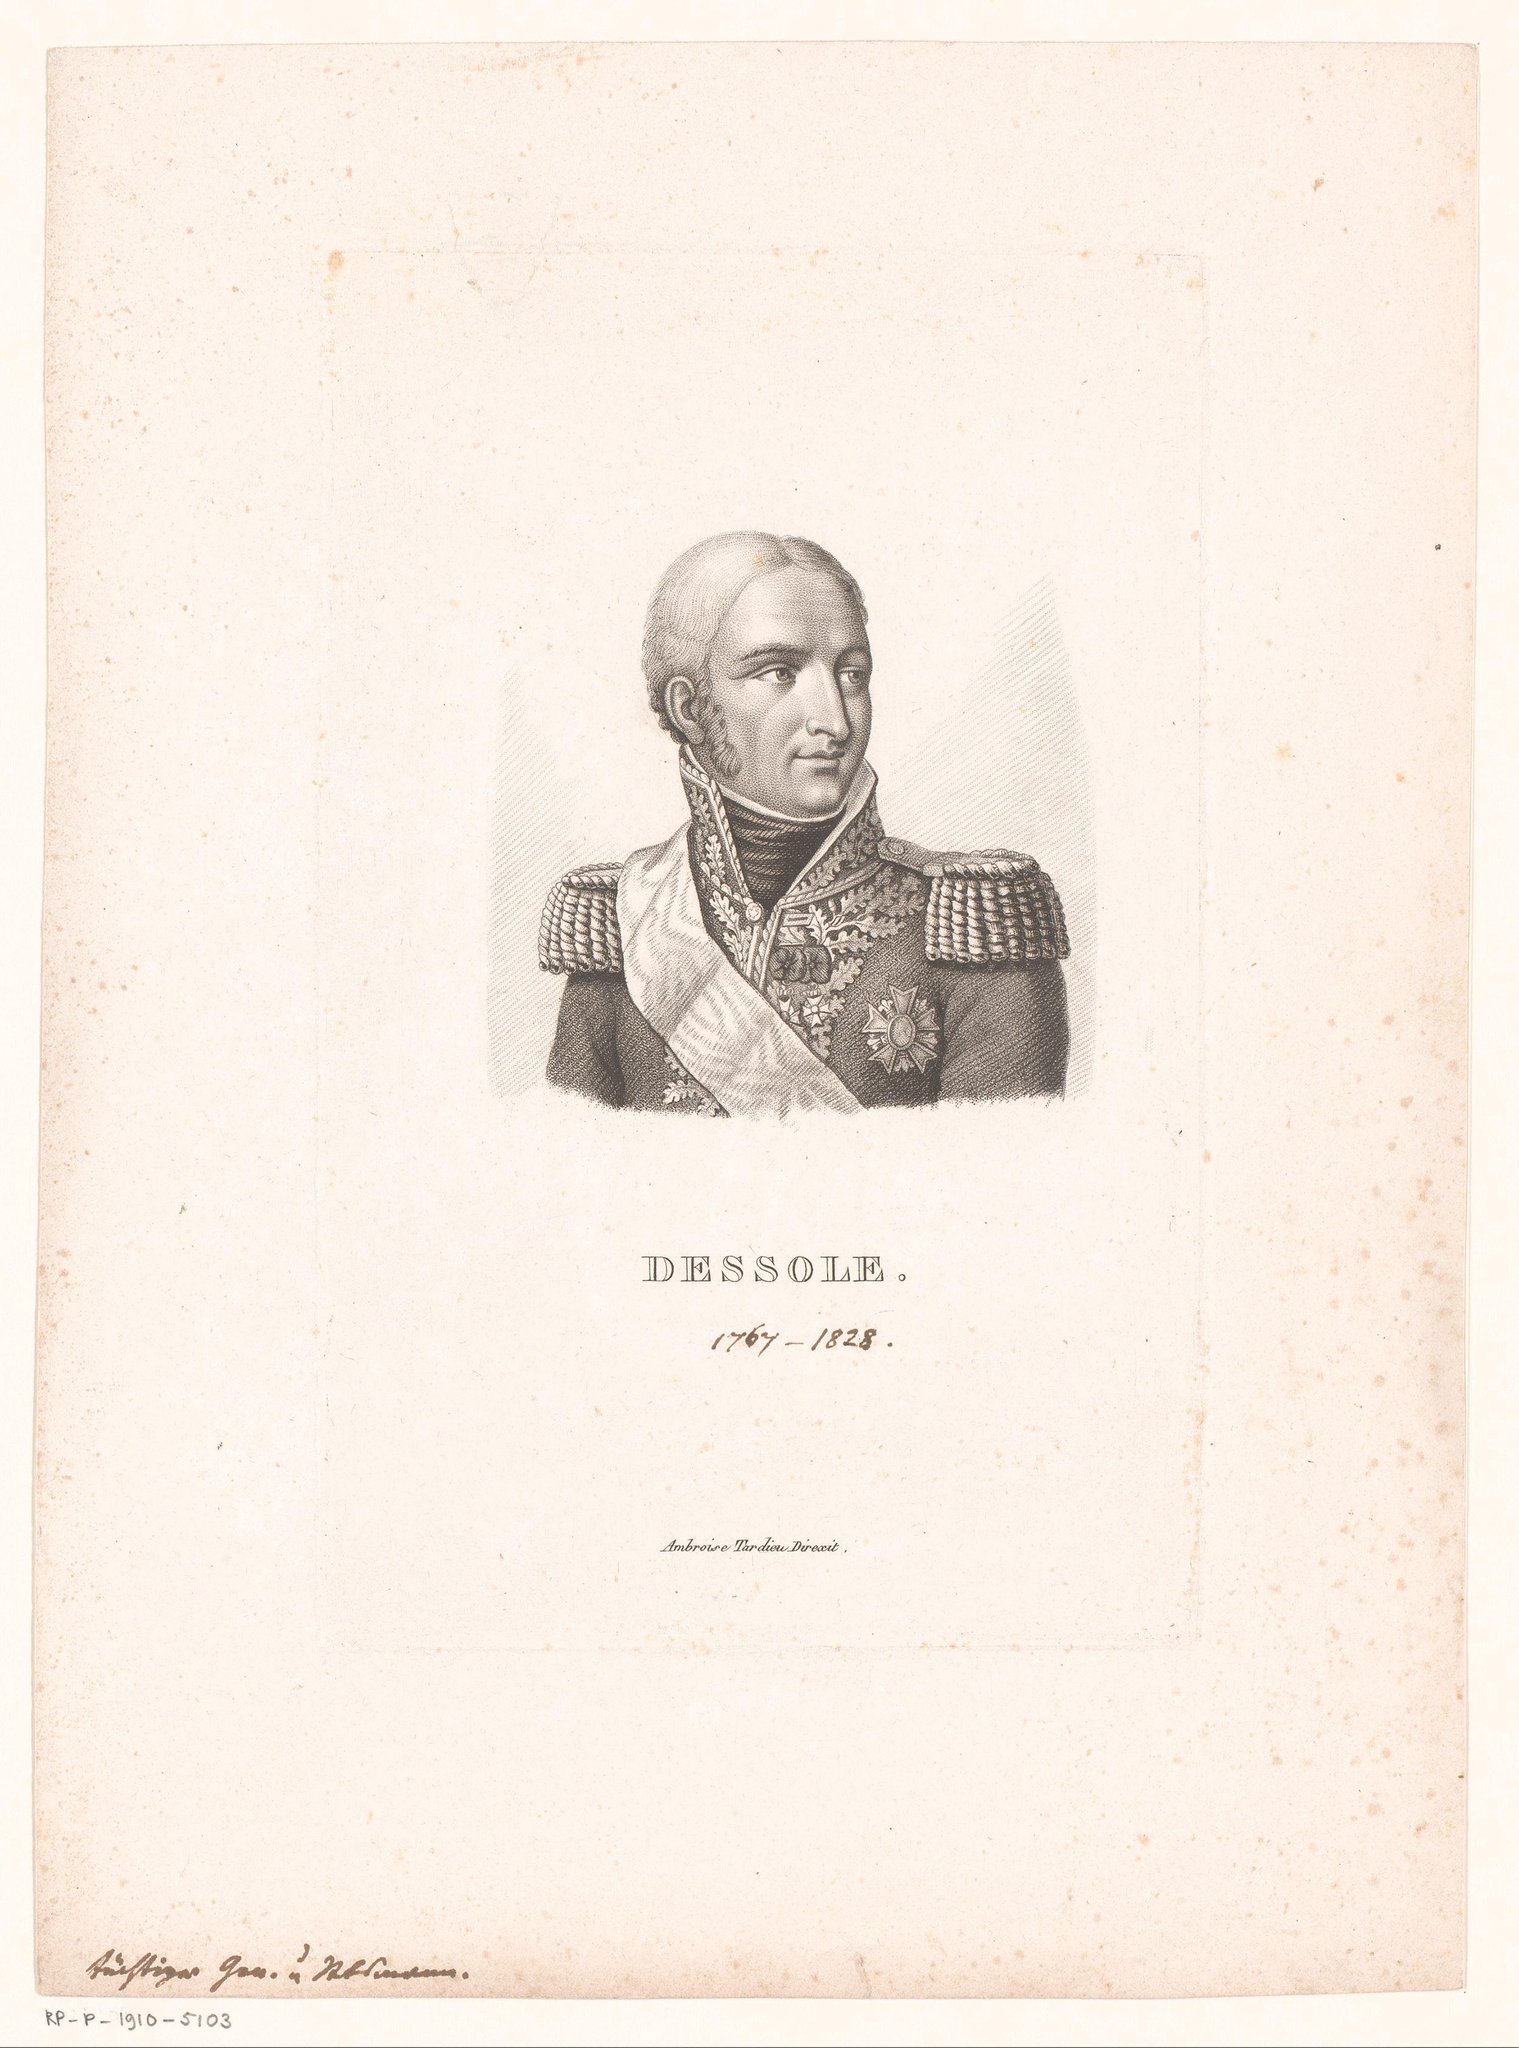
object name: book illustration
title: Portret van Jean-Joseph Dessolles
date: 1818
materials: paper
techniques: engraving, roulette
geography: france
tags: politician, commander-in-chief, general, marshal, historical persons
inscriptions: collector's mark: Lugt 2228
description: Mogelijk prent uit: Tardieu, Ambroise. Portraits des généraux français, faisant suite aux "Victoires et conquêtes des Français". Parijs: Panckoucke, Charles Louis Fleury, ca. 1818.